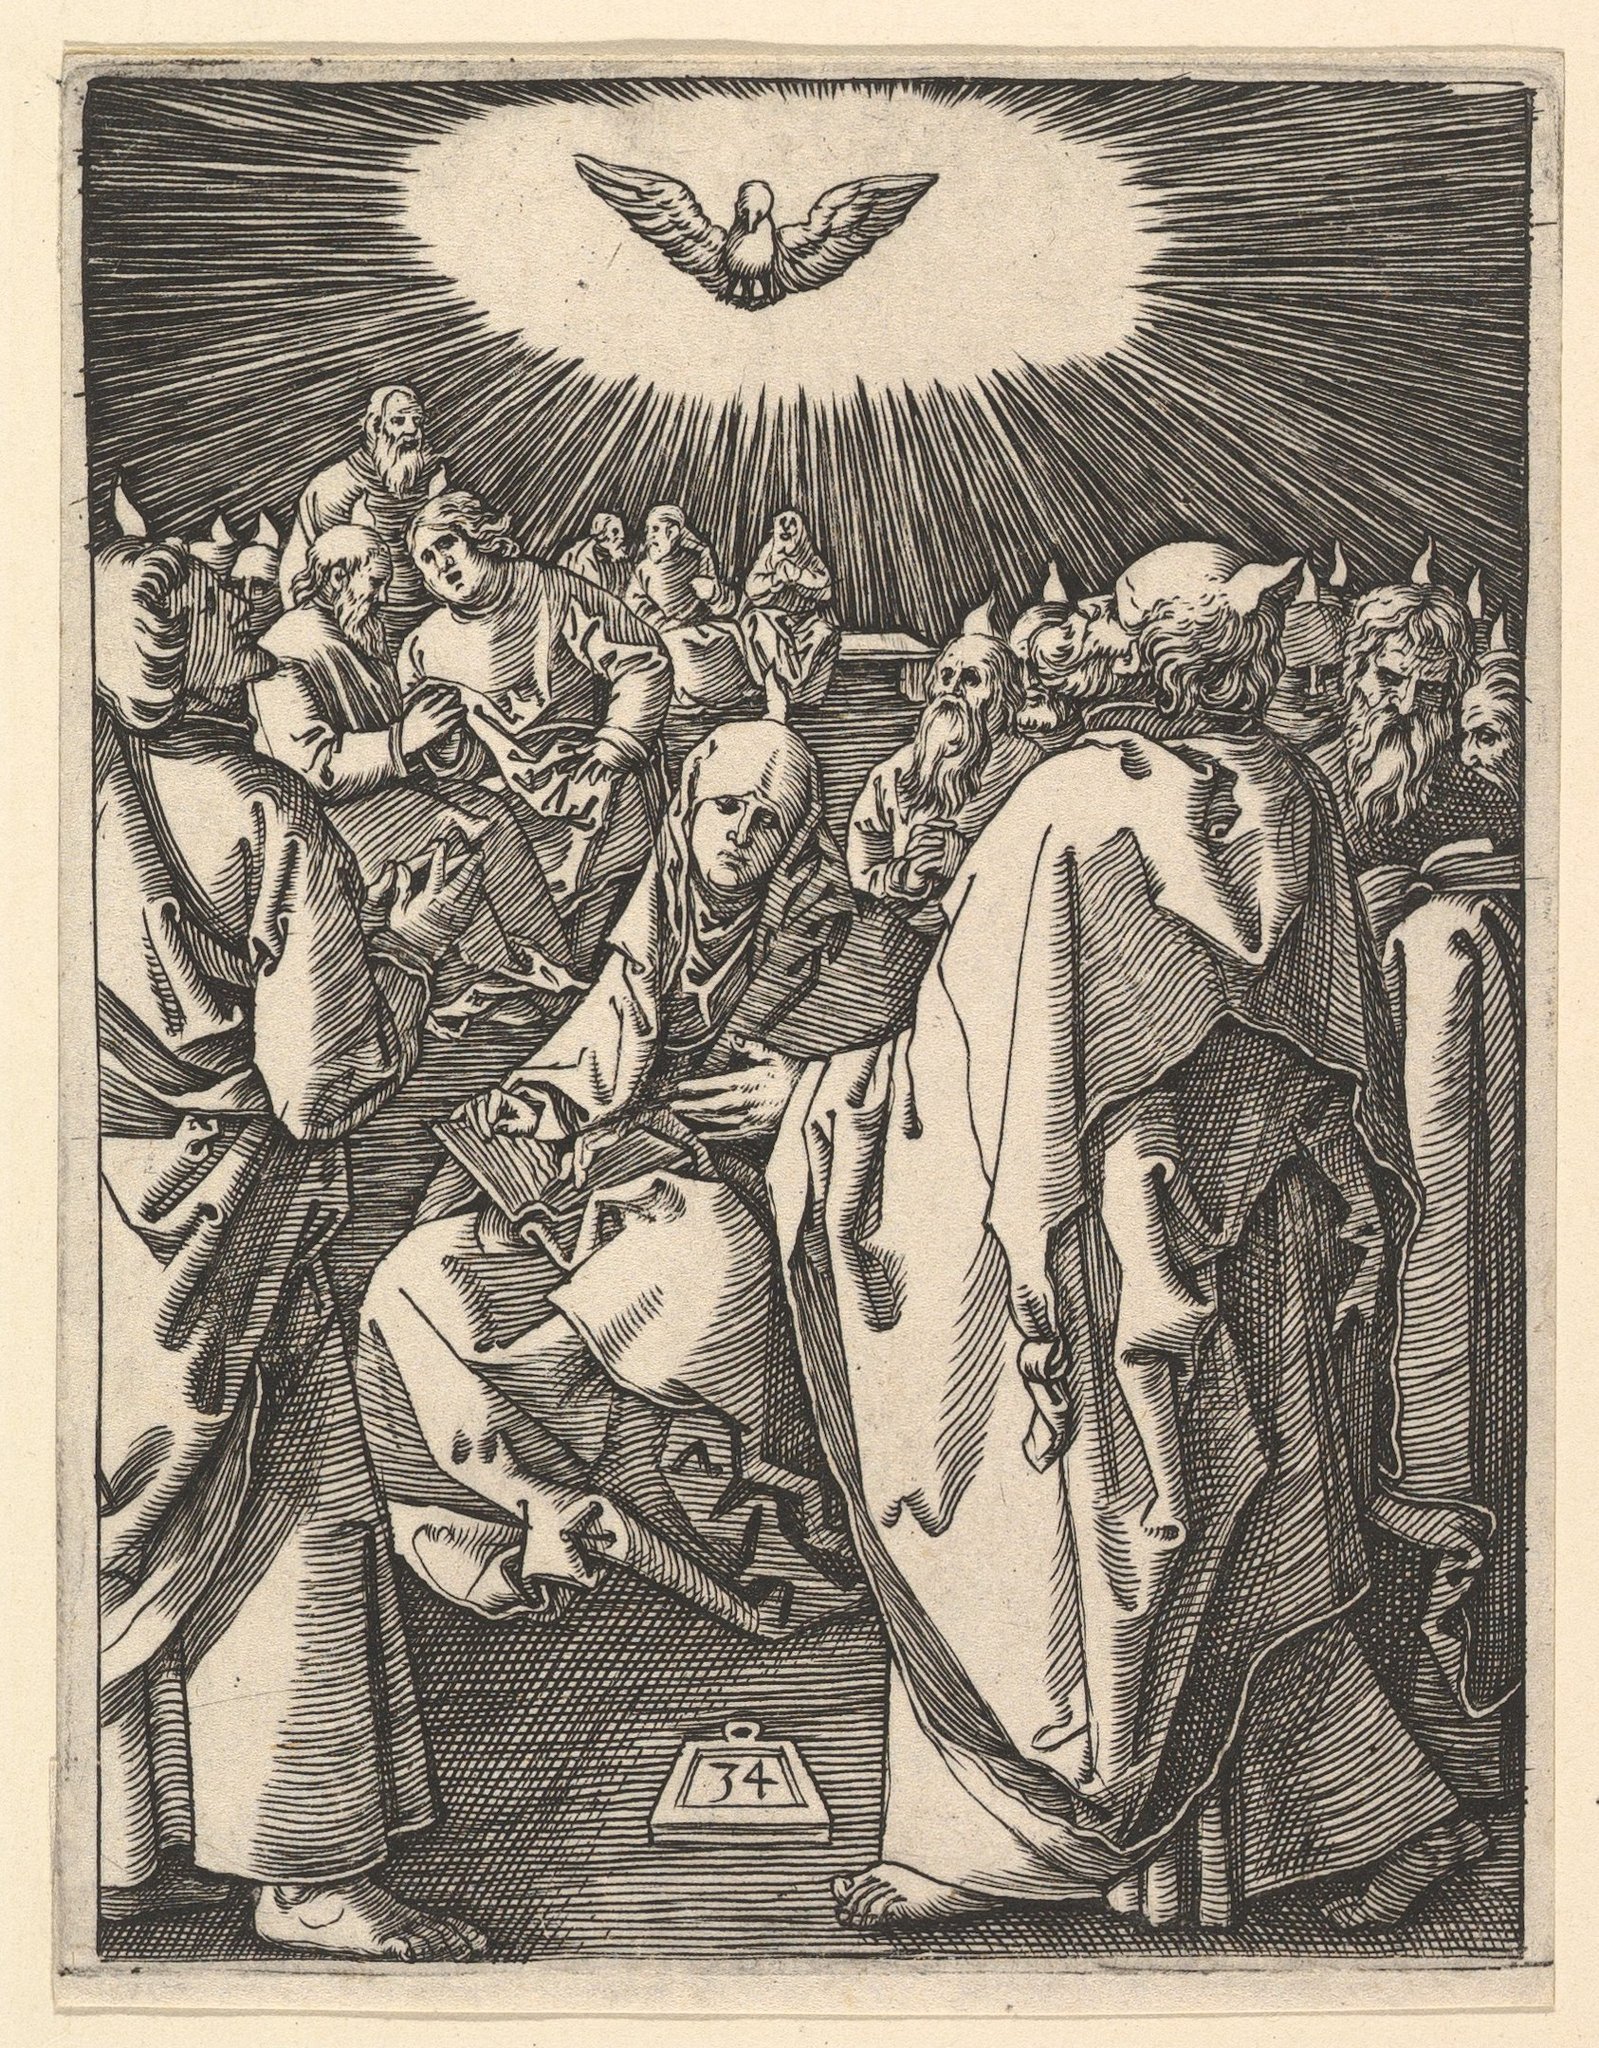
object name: print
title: The Pentecost; the Holy Dove appears above, below sits the Virgin surrounded by Apostles, from "The Passion of Christ"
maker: marcantonio raimondi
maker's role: artist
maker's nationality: italian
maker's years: 1475-1534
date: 1500-1534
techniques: engraving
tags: doves,apostles,virgin mary,pentecost